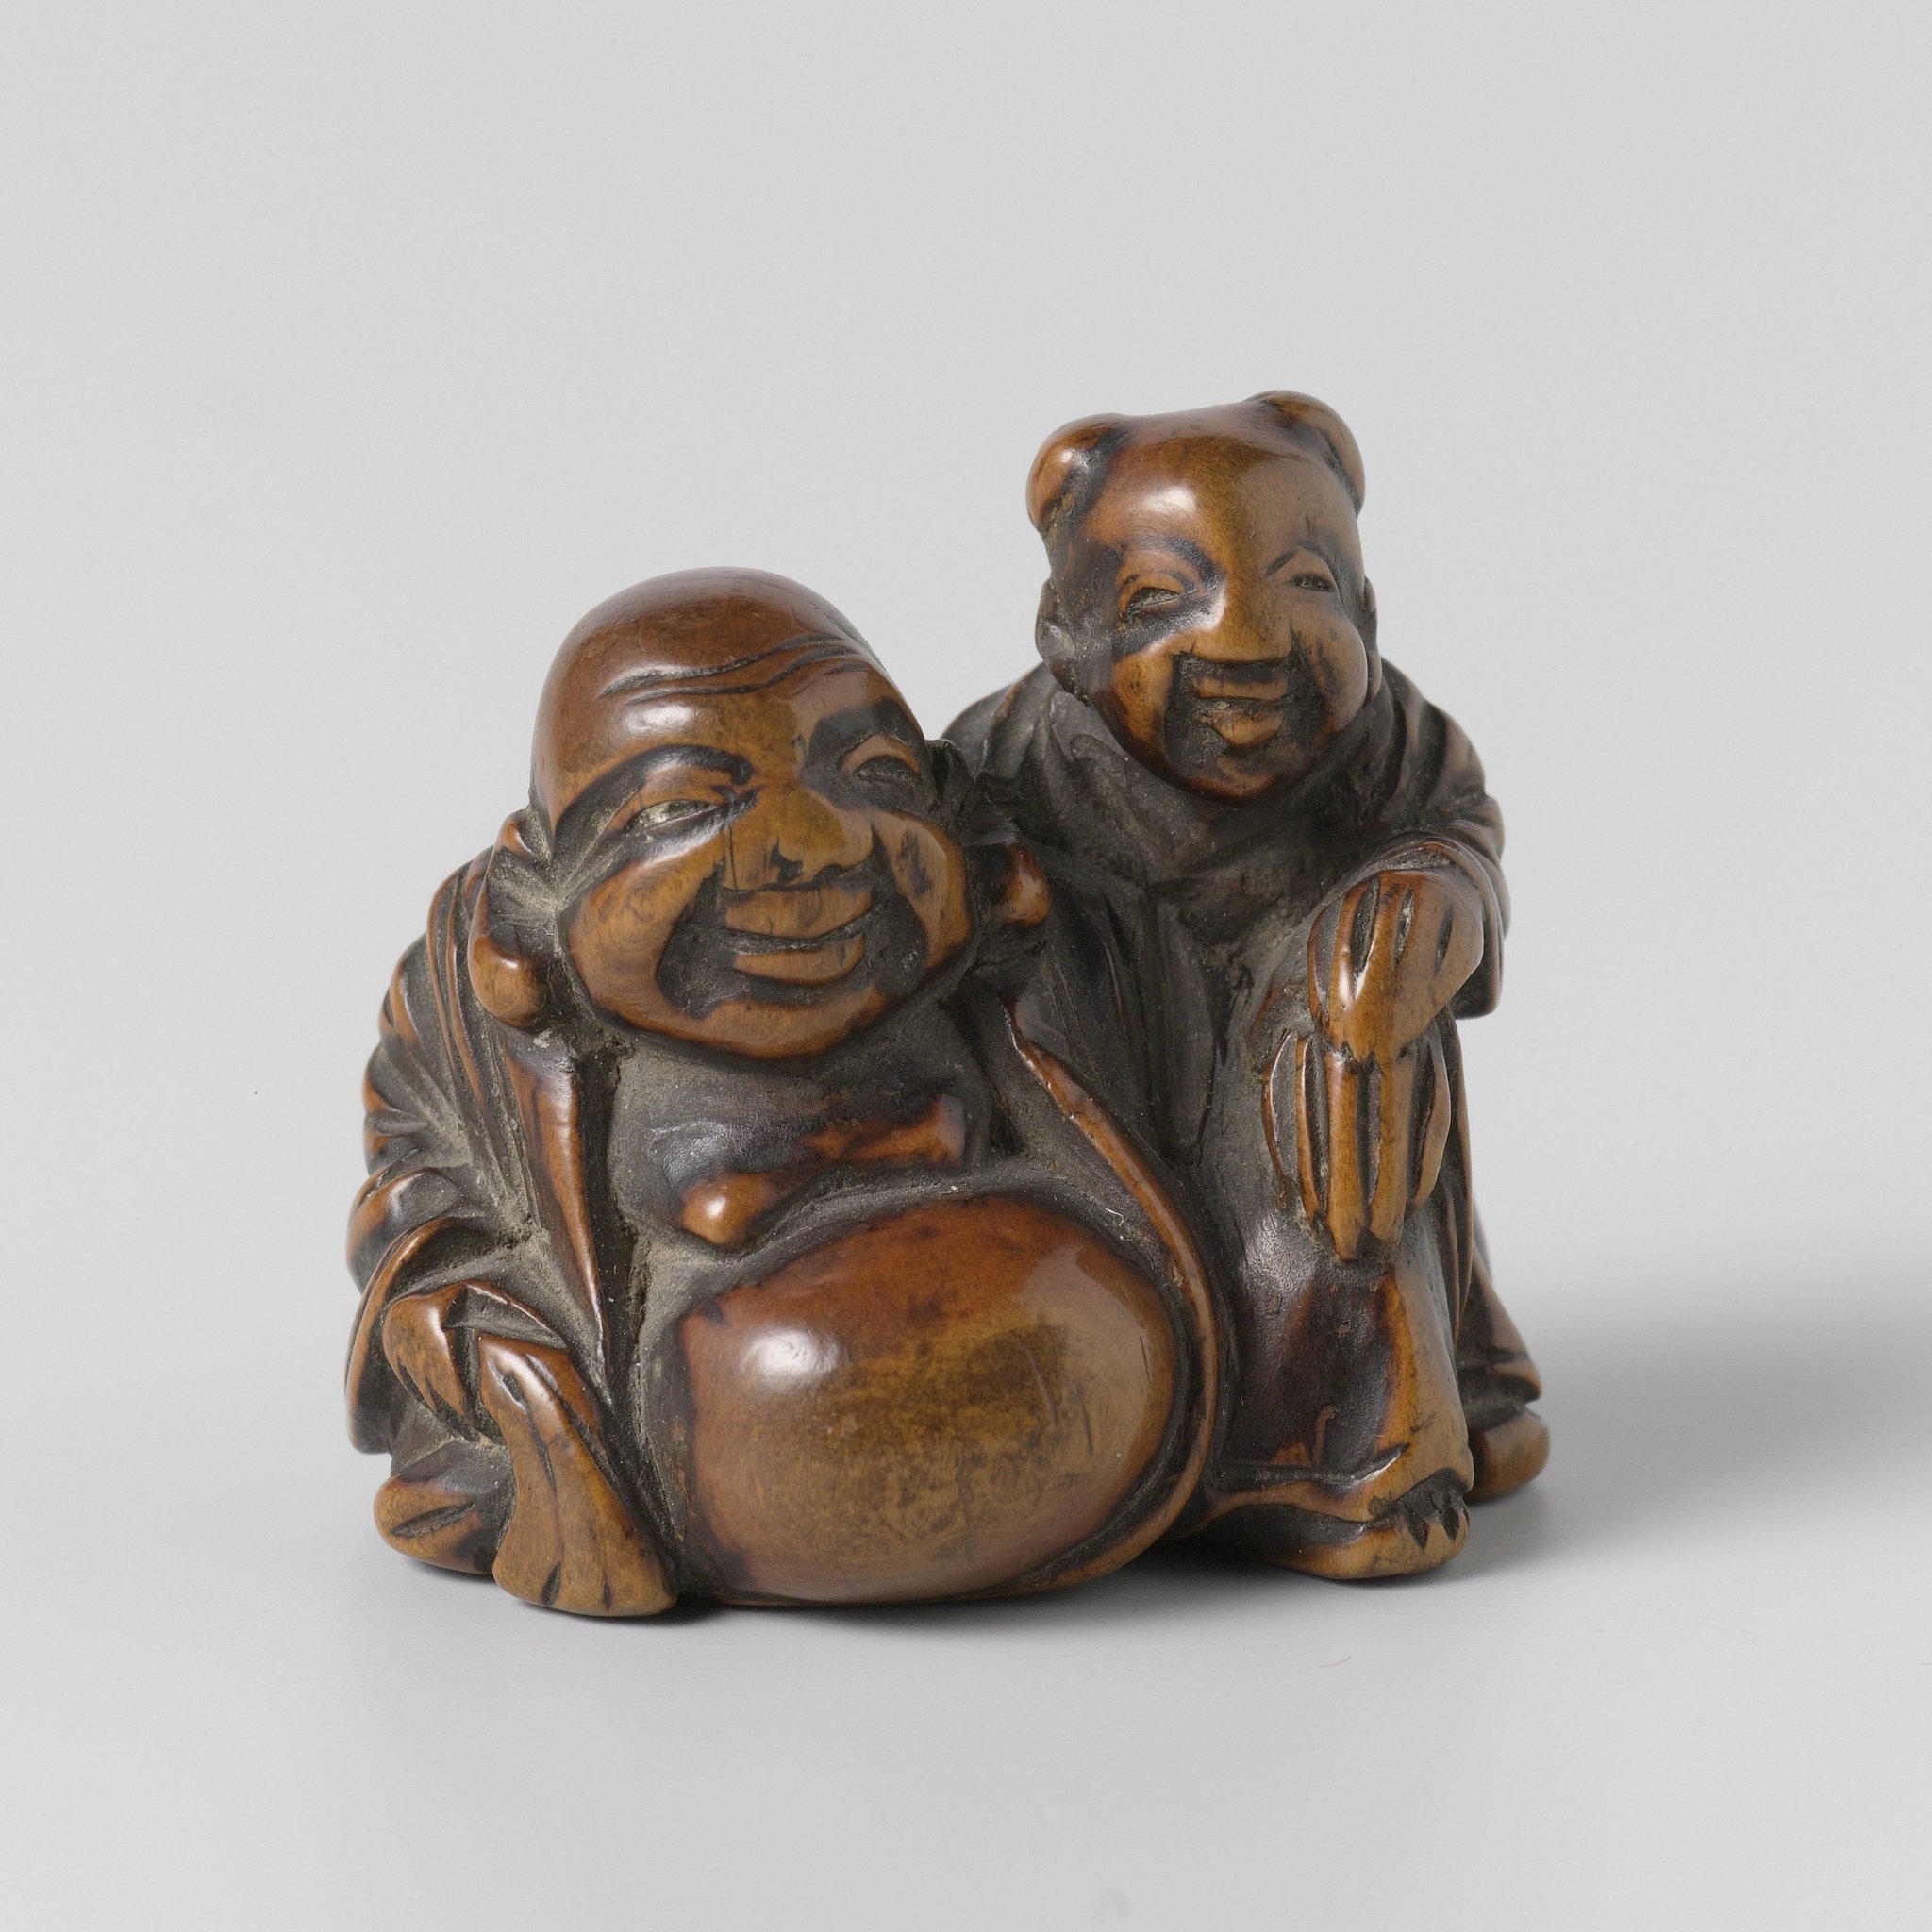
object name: netsuke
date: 1700-1850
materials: wood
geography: japan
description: De geluksgod Hotei en een Chinese knaap.